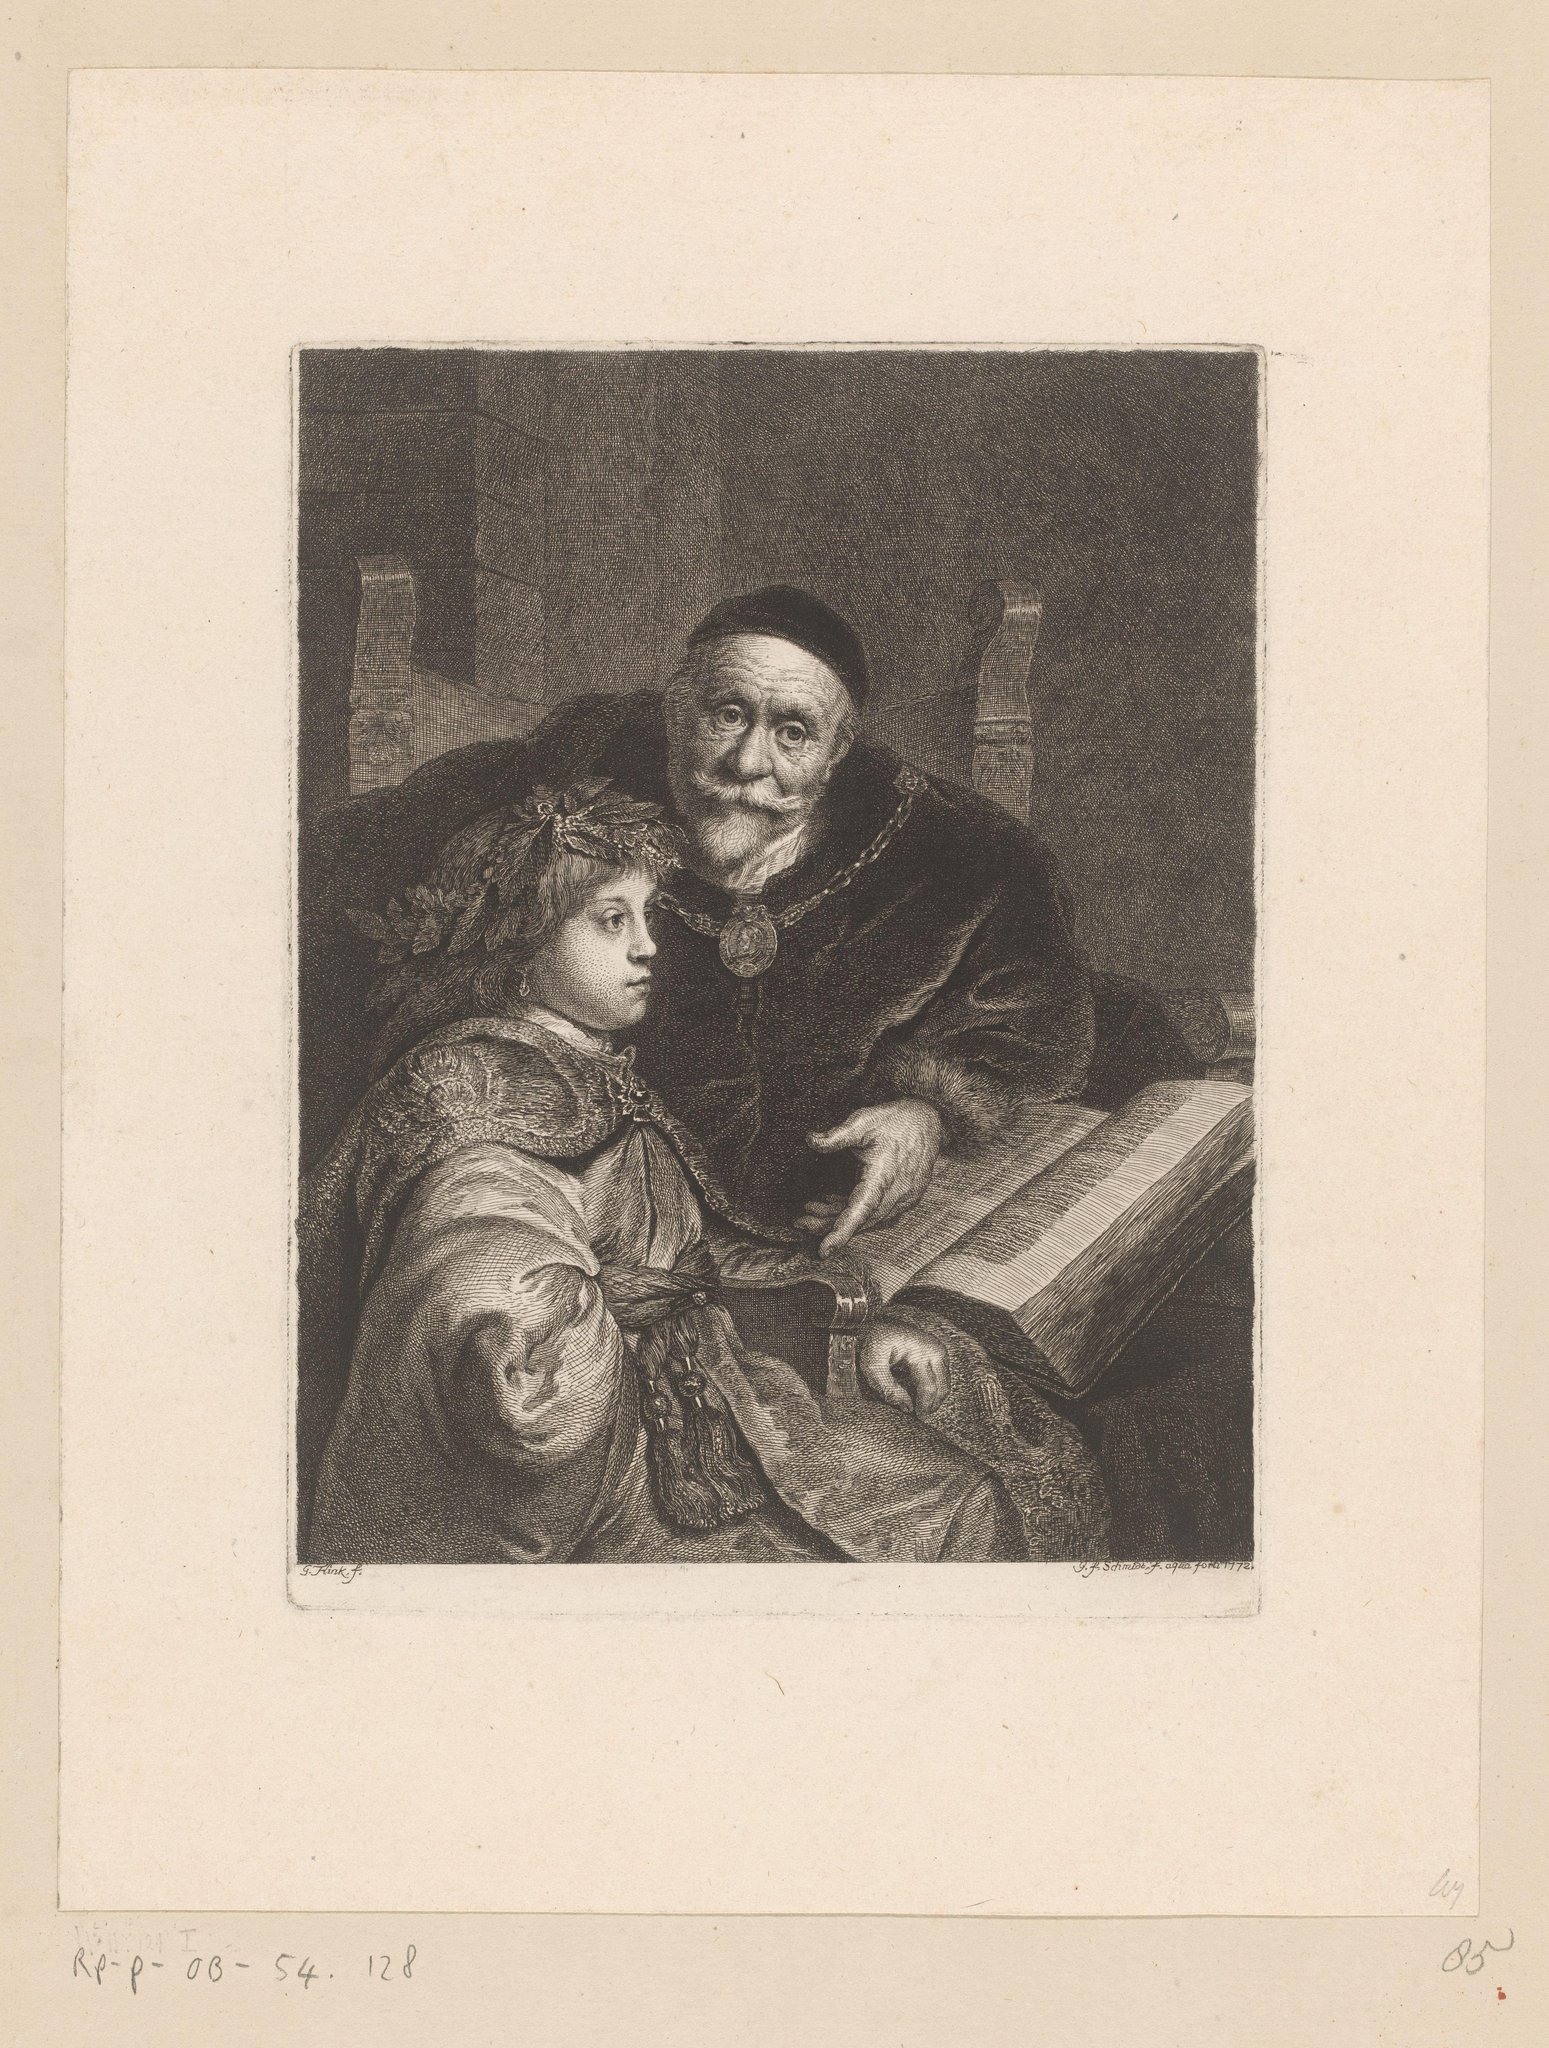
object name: print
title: Portret van Carl Ludwig van de Palts met Wolrad von Plessen in de rol van Alexander de Grote en Aristoteles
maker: georg friedrich schmidt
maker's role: draughtsman, print maker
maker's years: 1712-1775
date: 1772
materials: paper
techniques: etching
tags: leiden, historical persons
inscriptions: collector's mark: Lugt 240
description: Naar een schilderij van Jan Lievens gedateerd 1631, heden in The J. Paul Getty Museum, Los Angeles/Malibu , inv./cat.nr 71PA53.